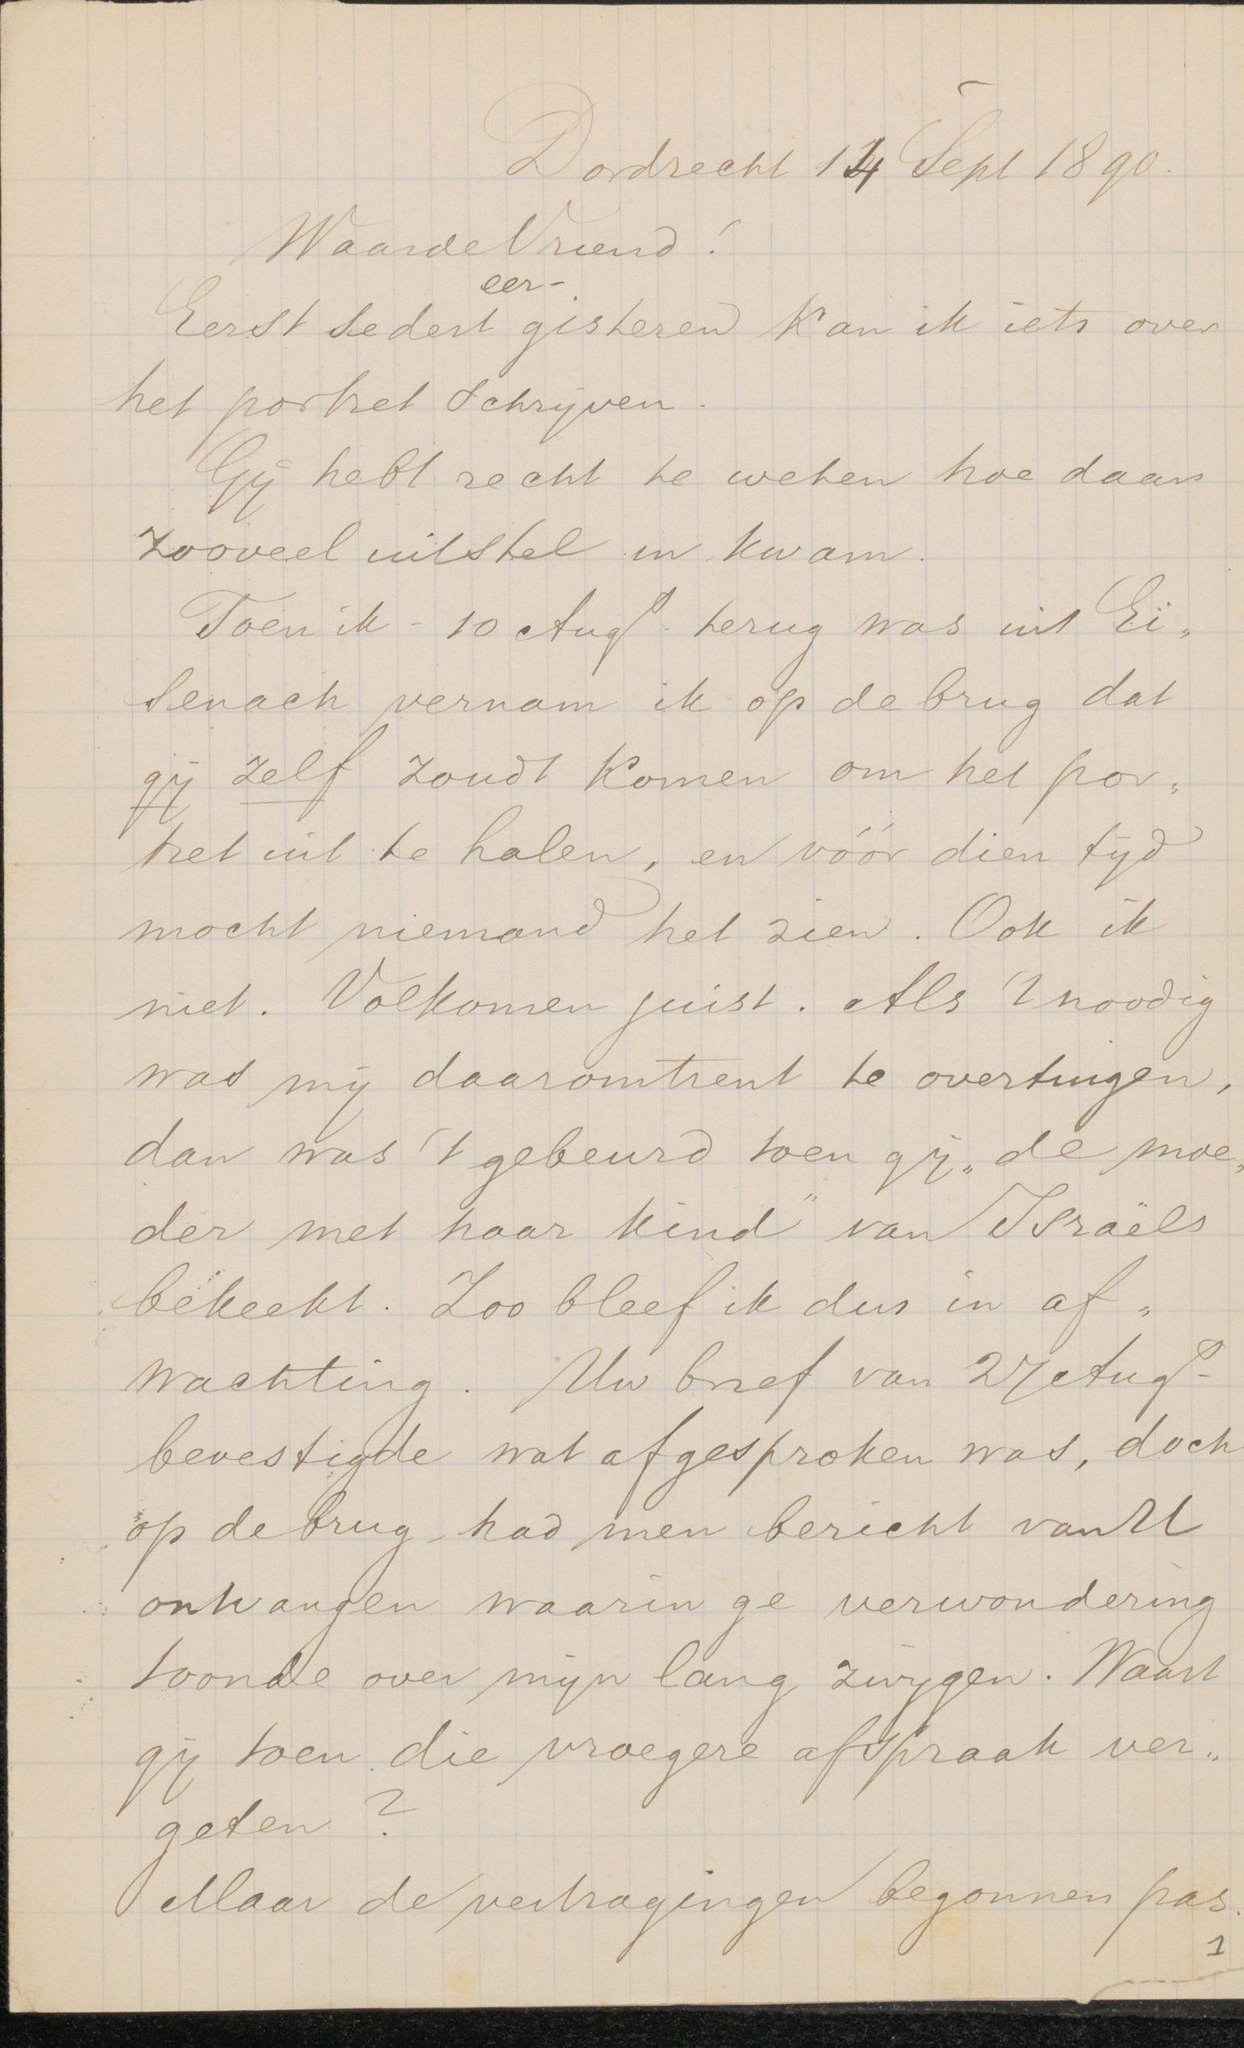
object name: letter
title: Brief aan Jan Veth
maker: martinus cornelis lebret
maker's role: verzamelaar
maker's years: 1833-1894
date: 1890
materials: ink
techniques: pen, writing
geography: dordrecht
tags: the hague, jozef israëls, amsterdam, painter, print maker, draughtsman, designer, jan veth, exhibition ~ art, diseases, historical persons (portraits and scenes from the life), arnhem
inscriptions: collector's mark: ‘RPK’